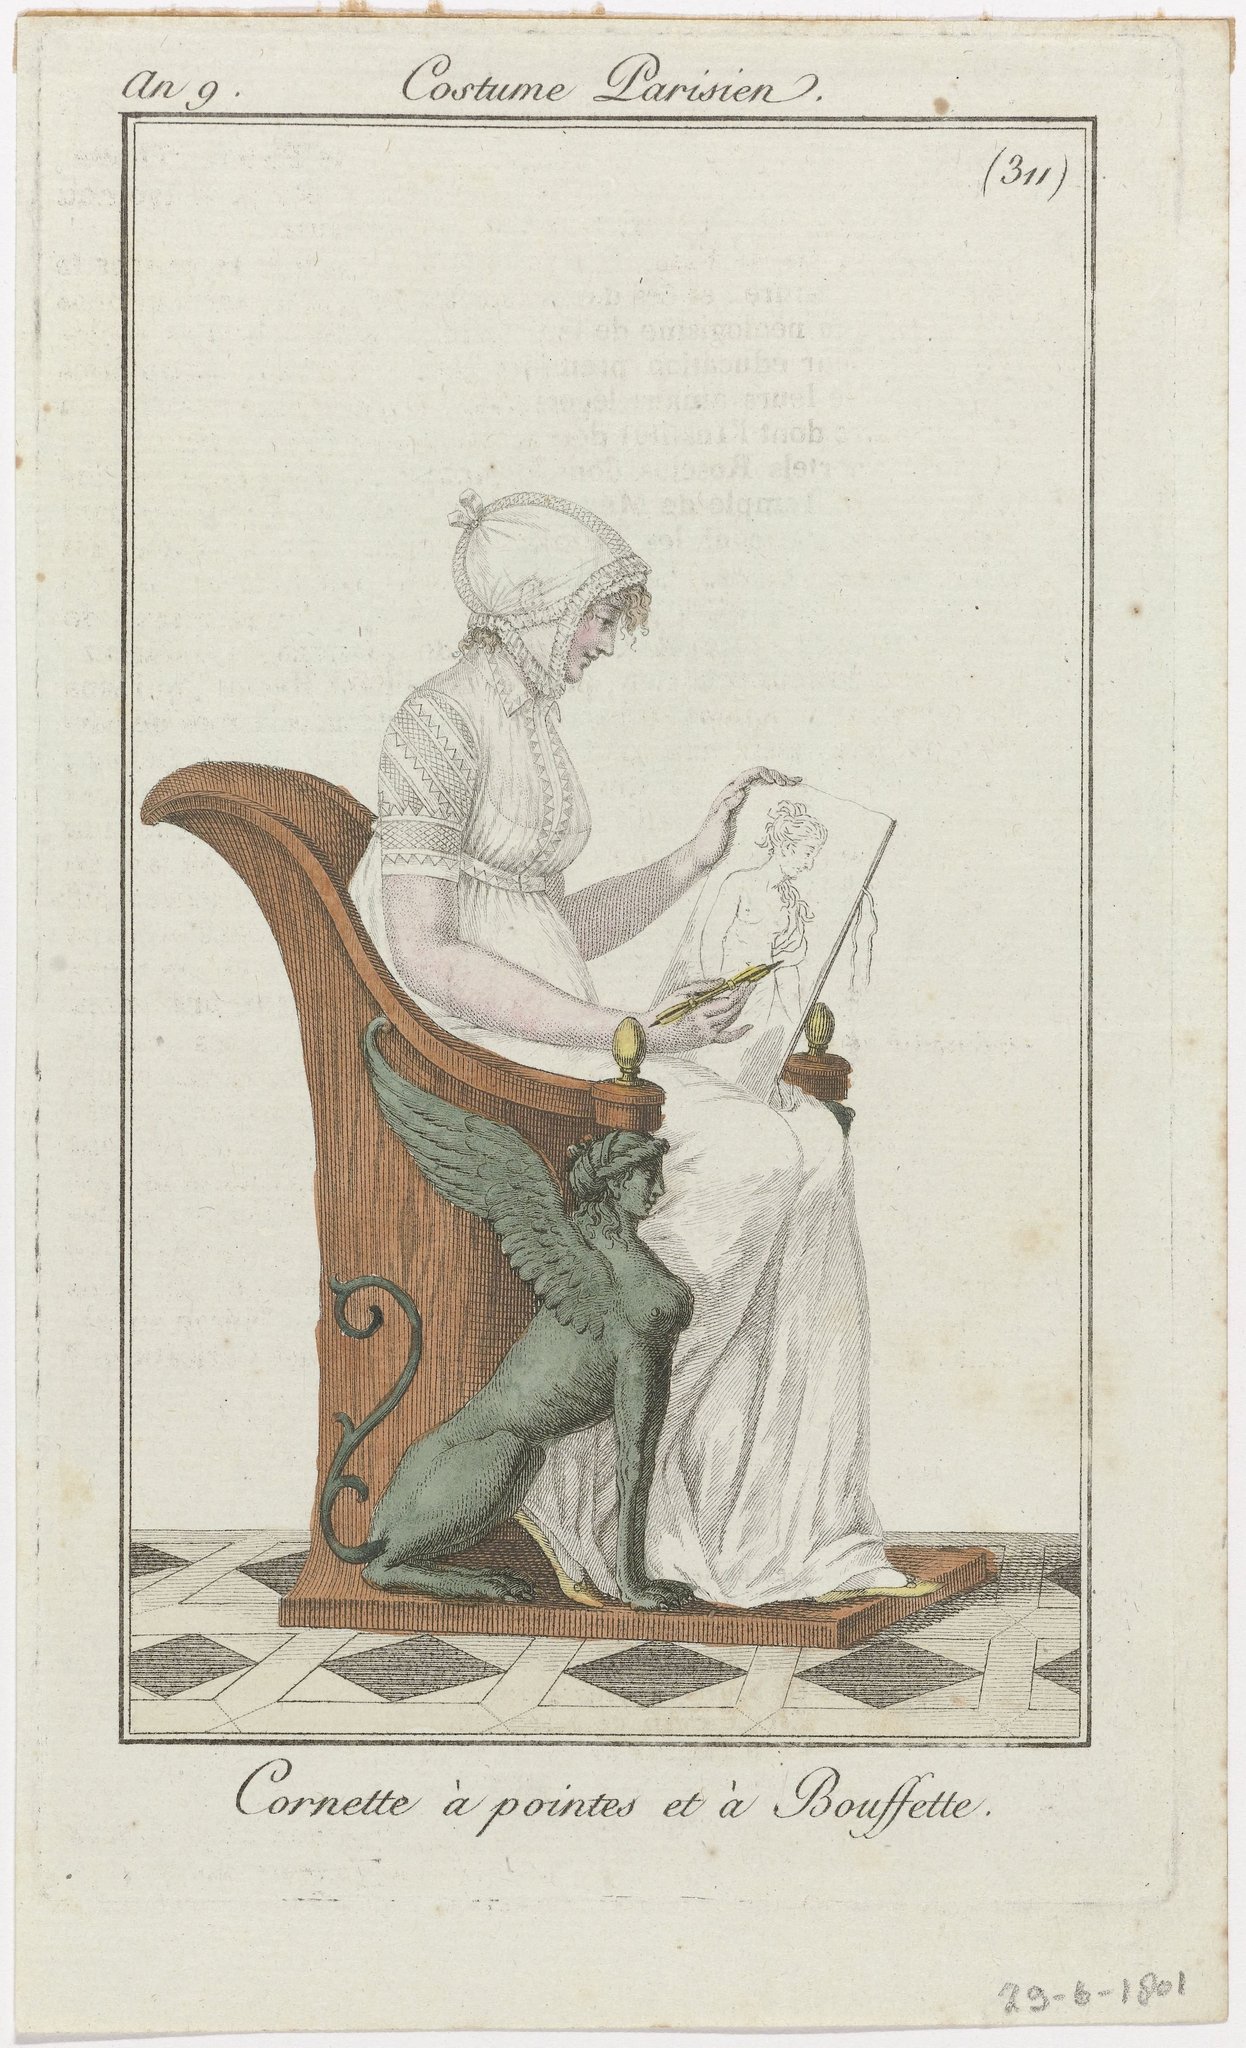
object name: fashion print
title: Journal des Dames et des Modes, Costume Parisien, 29 juin 1801, An 9, (311) : Cornette à pointes (...)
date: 1801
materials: paper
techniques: engraving, hand coloring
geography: paris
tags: drawing, sketch, armchair, seat, clothing for the upper part of the body: blouse (+ women's clothes), head-gear (cornette) (+ women's clothes), fashion plates, shoes, sandals (+ women's clothes), dress, gown (+ women's clothes)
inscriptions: caption: ‘Cornette à pointes et à Bouffette.’, title: ‘Costume Parisien.’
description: Vrouw, zittend op een stoel, met op het hoofd een 'cornette' met punten en een 'bouffette' (strikje). Zij draagt een 'canezou' met een geometrisch patroon op een japon. platte schoenen met strikken. Schetsboek en een tekenpen in de handen. De prent maakt deel uit van het modetijdschrift Journal des Dames et des Modes, uitgegeven door Pierre de la Mésangère, Parijs, 1797-1839.